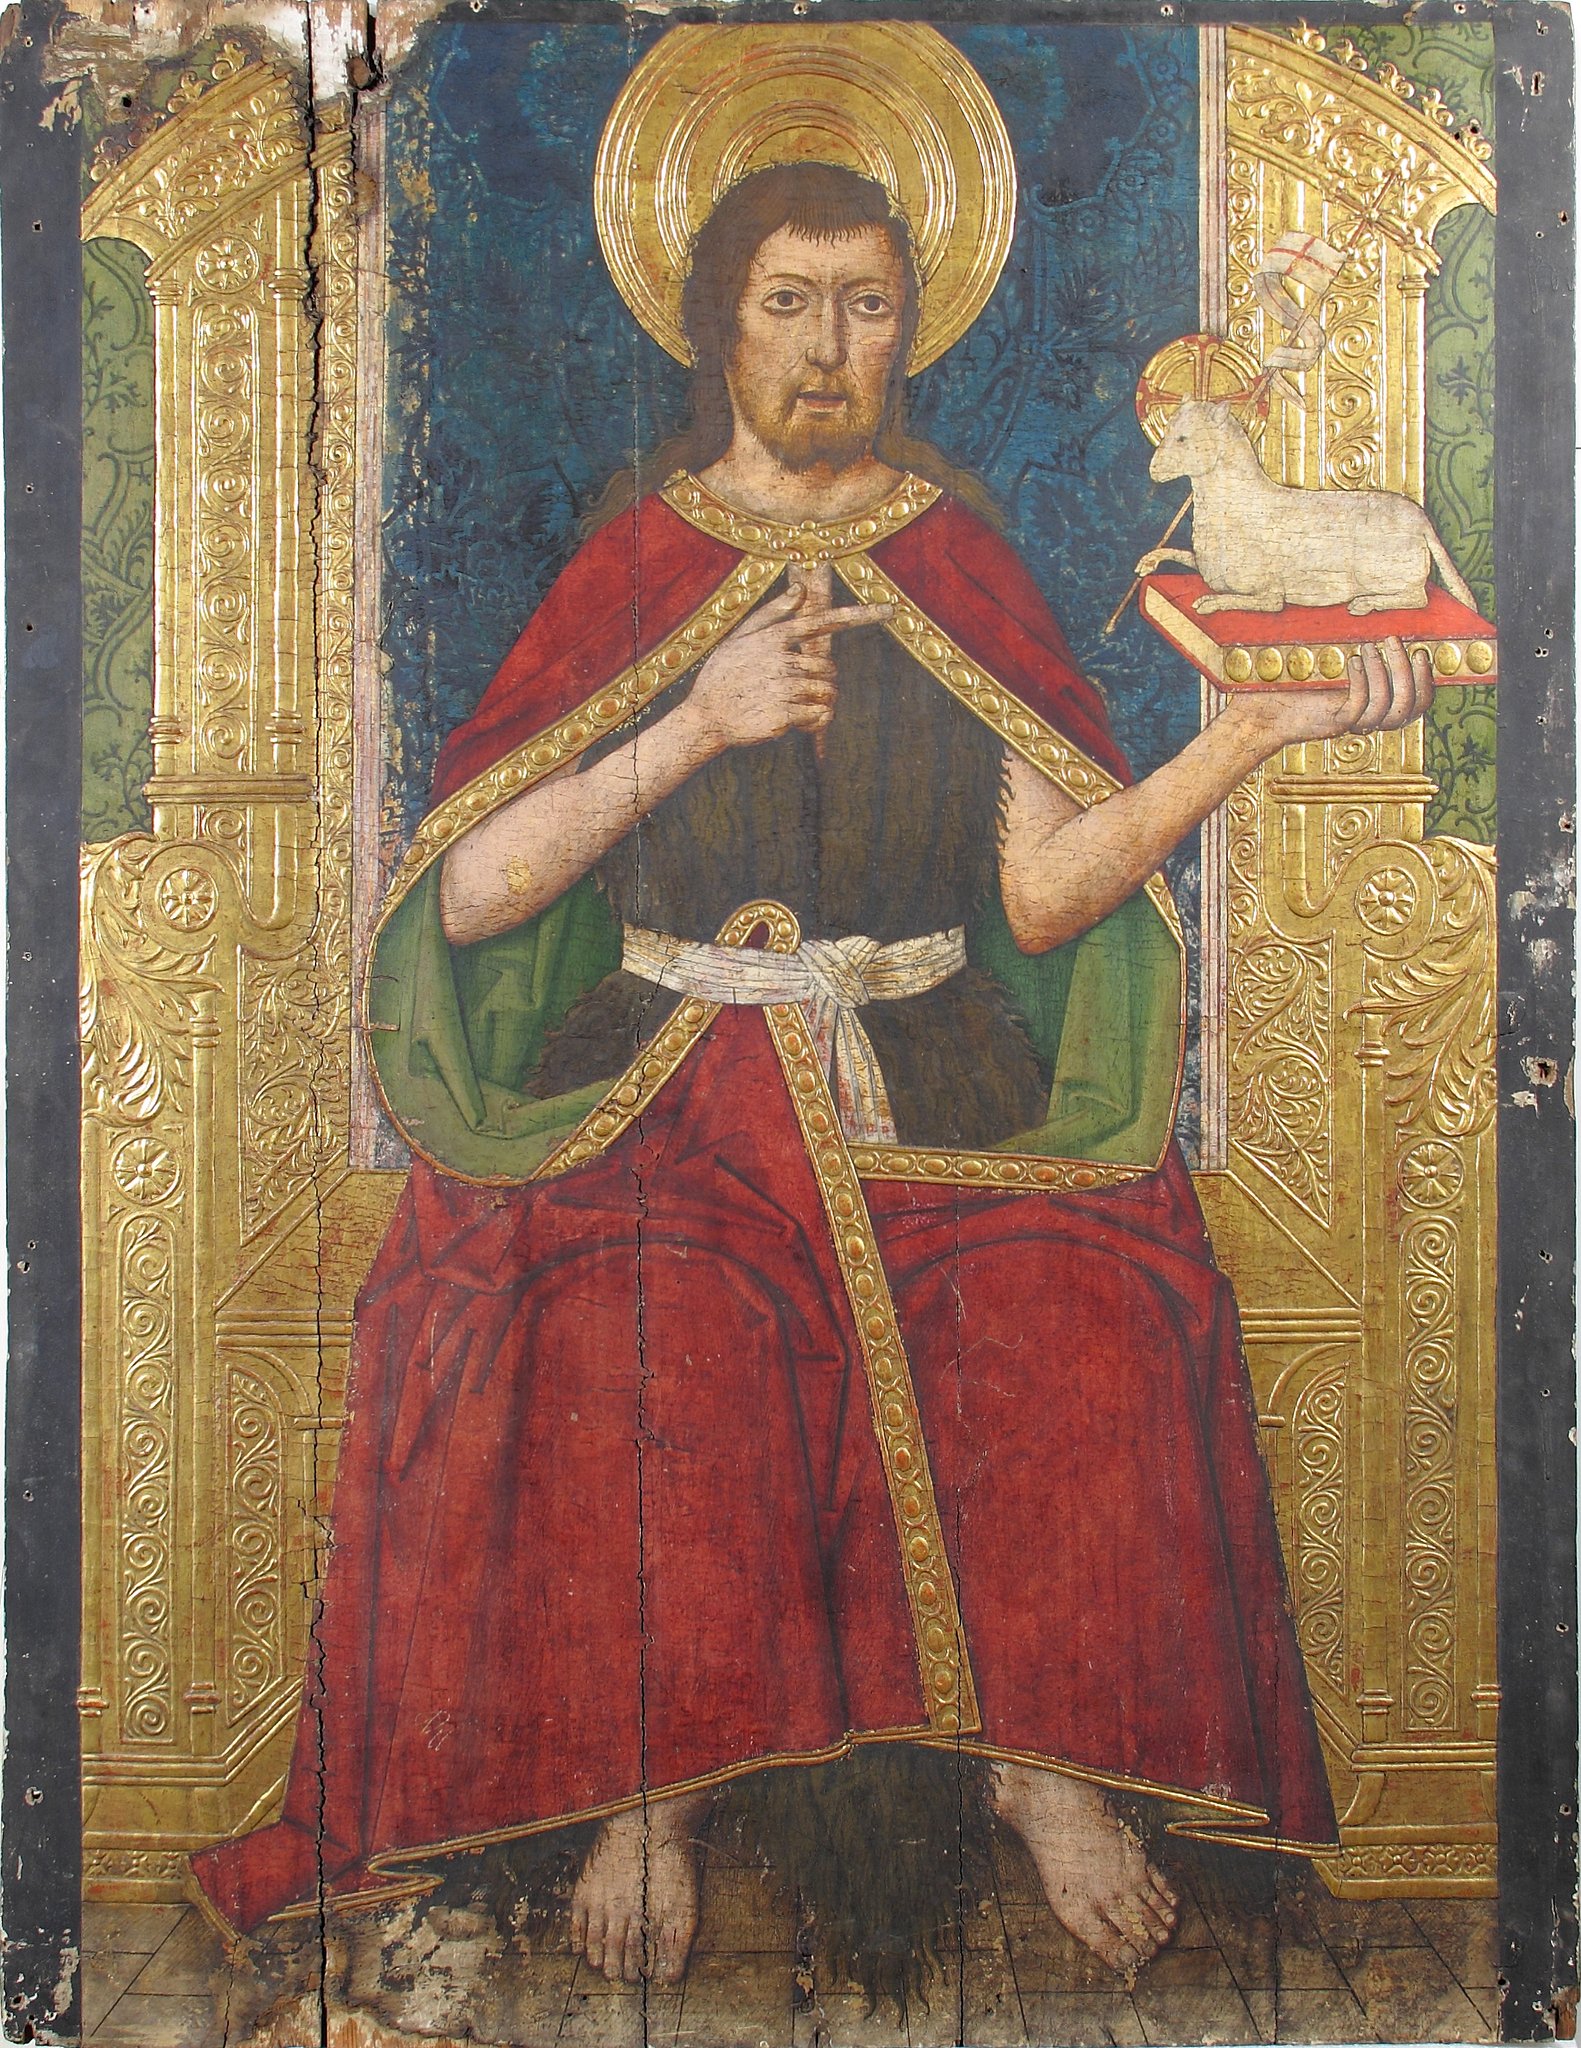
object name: painting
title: Panel with Saint John the Baptist Enthroned from Retable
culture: spanish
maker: domingo ram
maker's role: artist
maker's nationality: spanish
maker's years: 1464-1507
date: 1401-1500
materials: gold leaf, paint, wood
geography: spain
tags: lambs,saint john the baptist